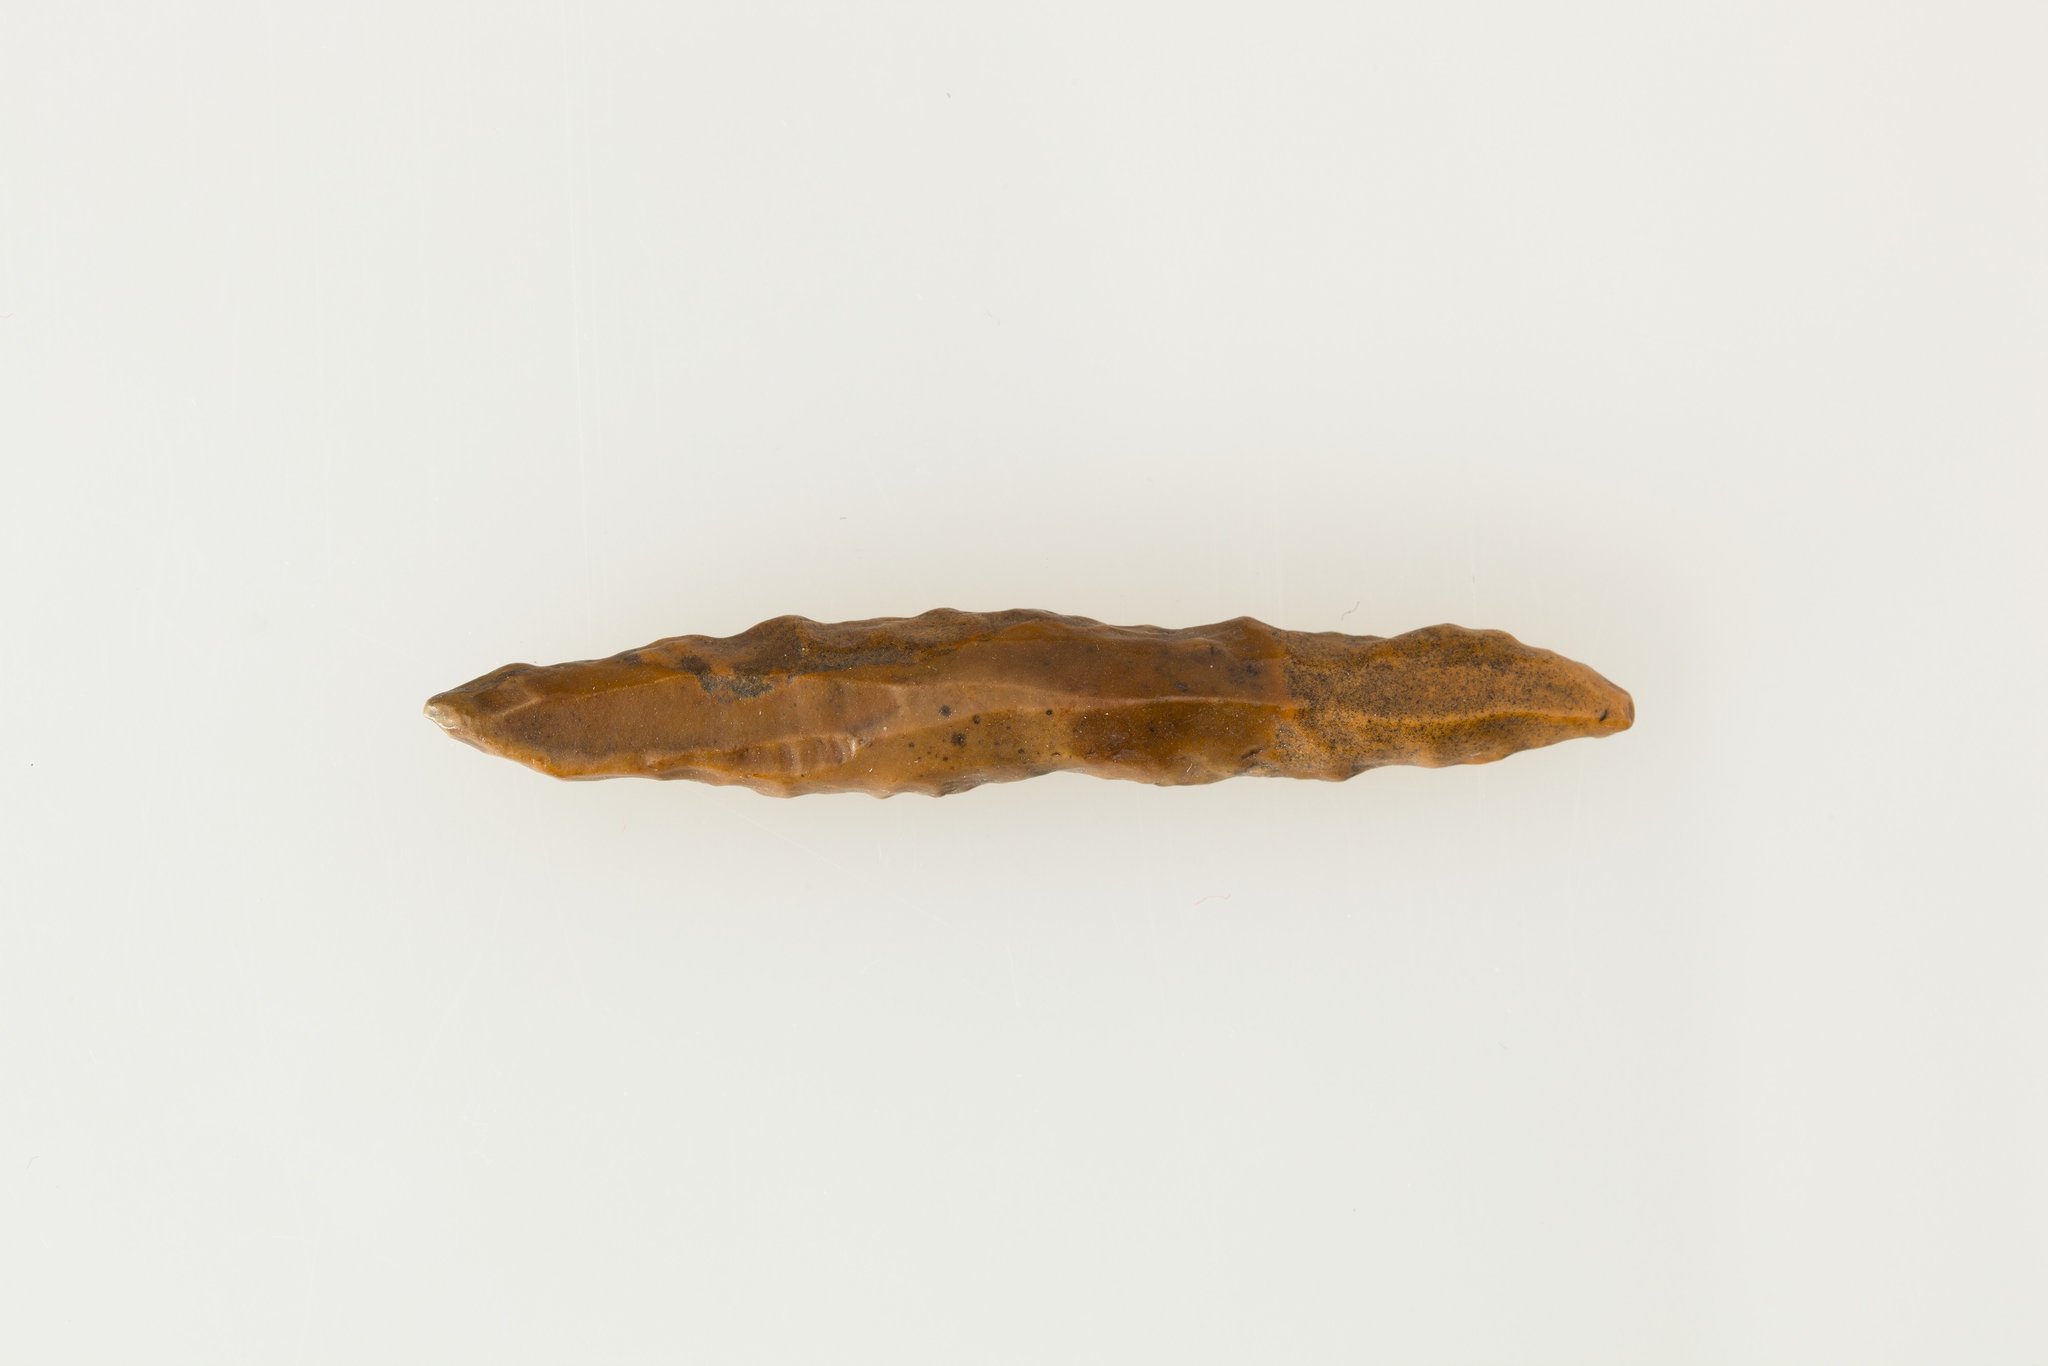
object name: tool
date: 3850-2960 BCE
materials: stone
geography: egypt